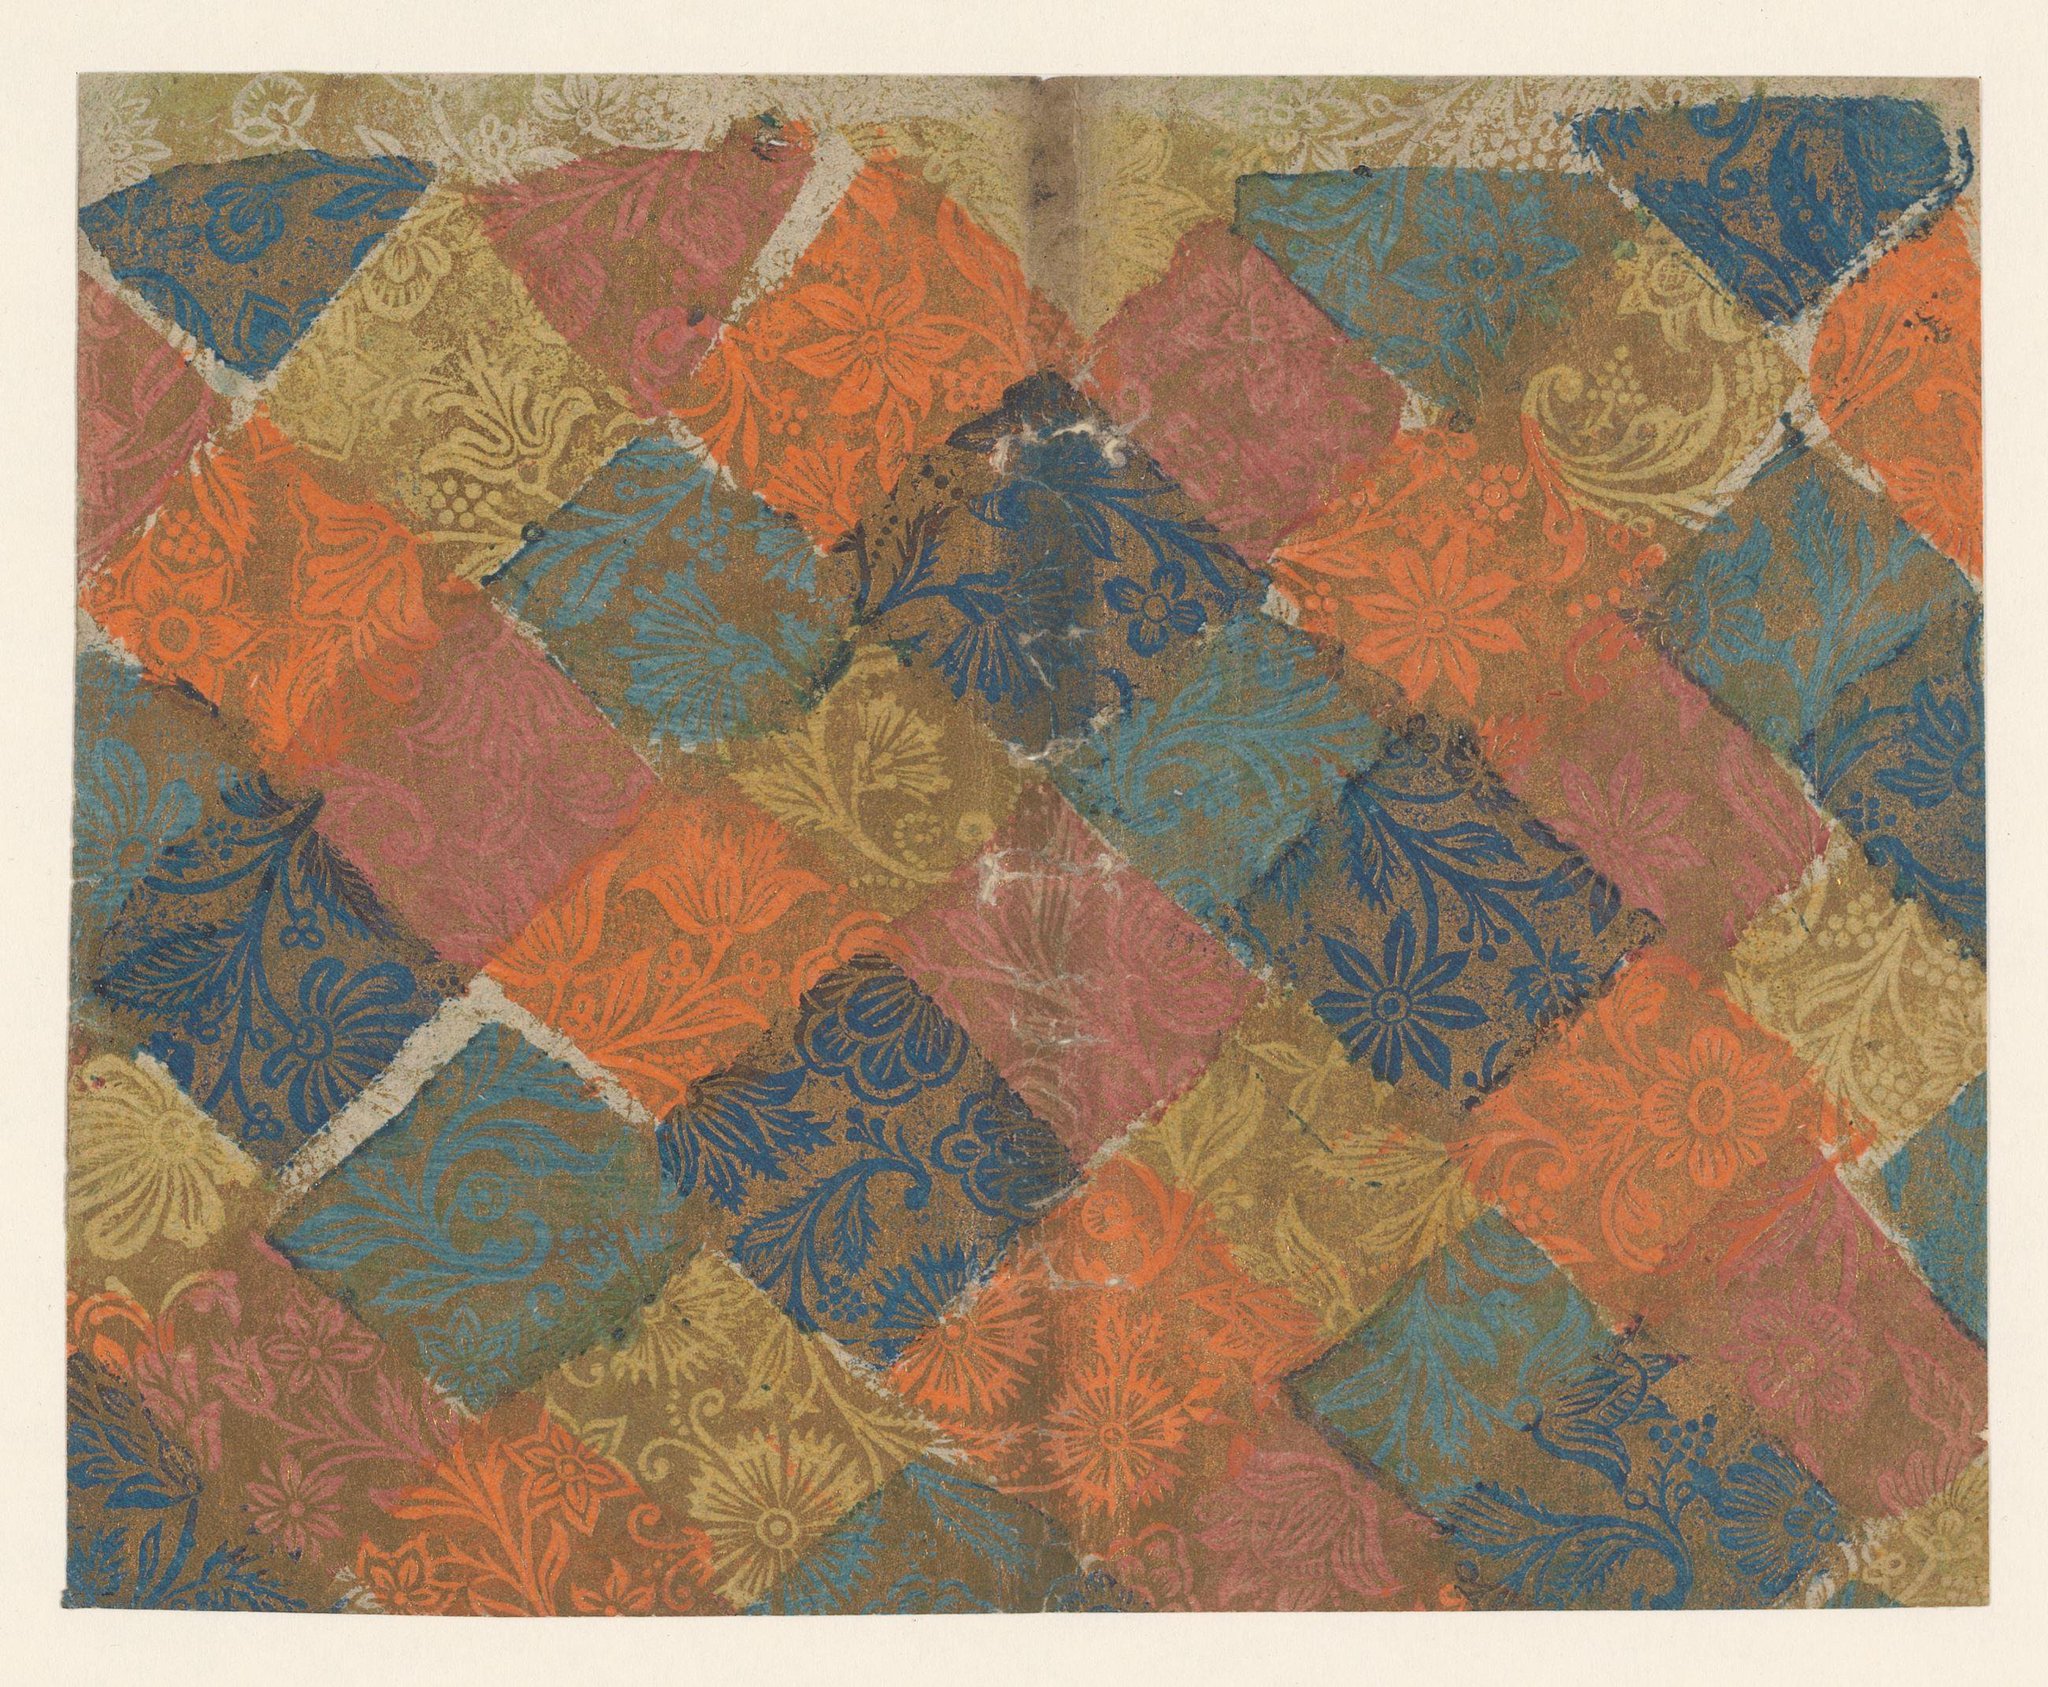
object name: brocade paper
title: Blad met ranken met bloemen en vruchten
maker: Anonymous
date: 1700-1850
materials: gold leaf, paint, paper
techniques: relief print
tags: ornament derived from plant forms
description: Blad met ranken met bloemen en vruchten, met kleuring in ruitenpatroon. Gebruikt als omslag.